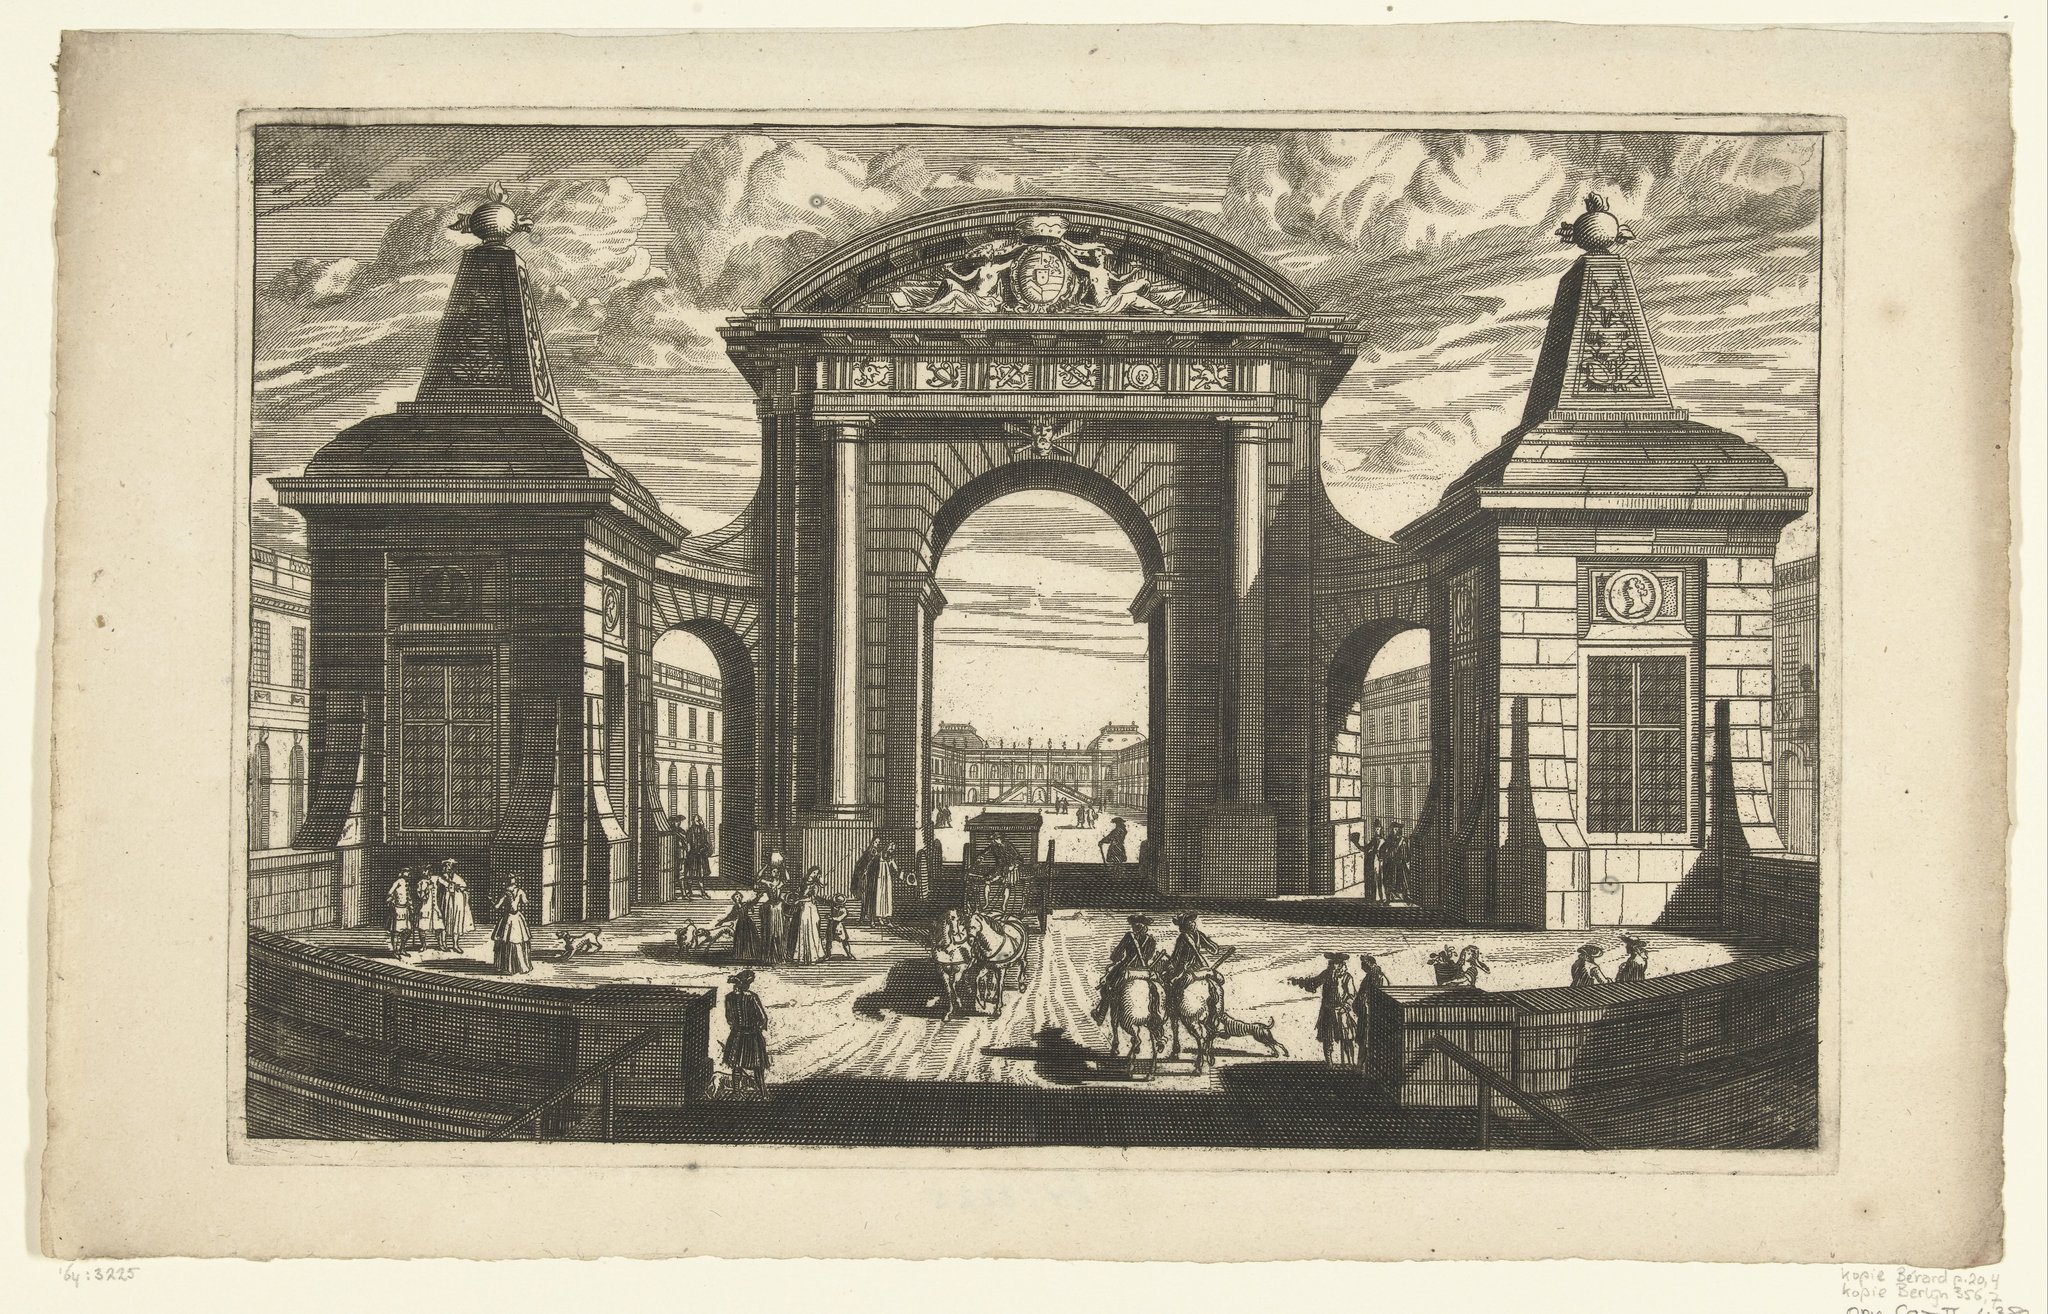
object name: ornament print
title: Stadspoort in de vorm van een triomfboog, met Toscaanse zuilen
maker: Anonymous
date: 1600-1699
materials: paper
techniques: etching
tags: tuscan order ~ architecture, triumphal arch, city-gate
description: Het middelste gedeelte is gedecoreerd met verzonken Tuscaanse zuilen en bekroond met een fronton met een wapenschild. Blad 3 uit serie van 6 bladen, tegenzijdige kopie naar blad uit de serie Second Liure d'Arc de Triomphe et Porte de Ville uitgegeven door Daniel Marot (I).